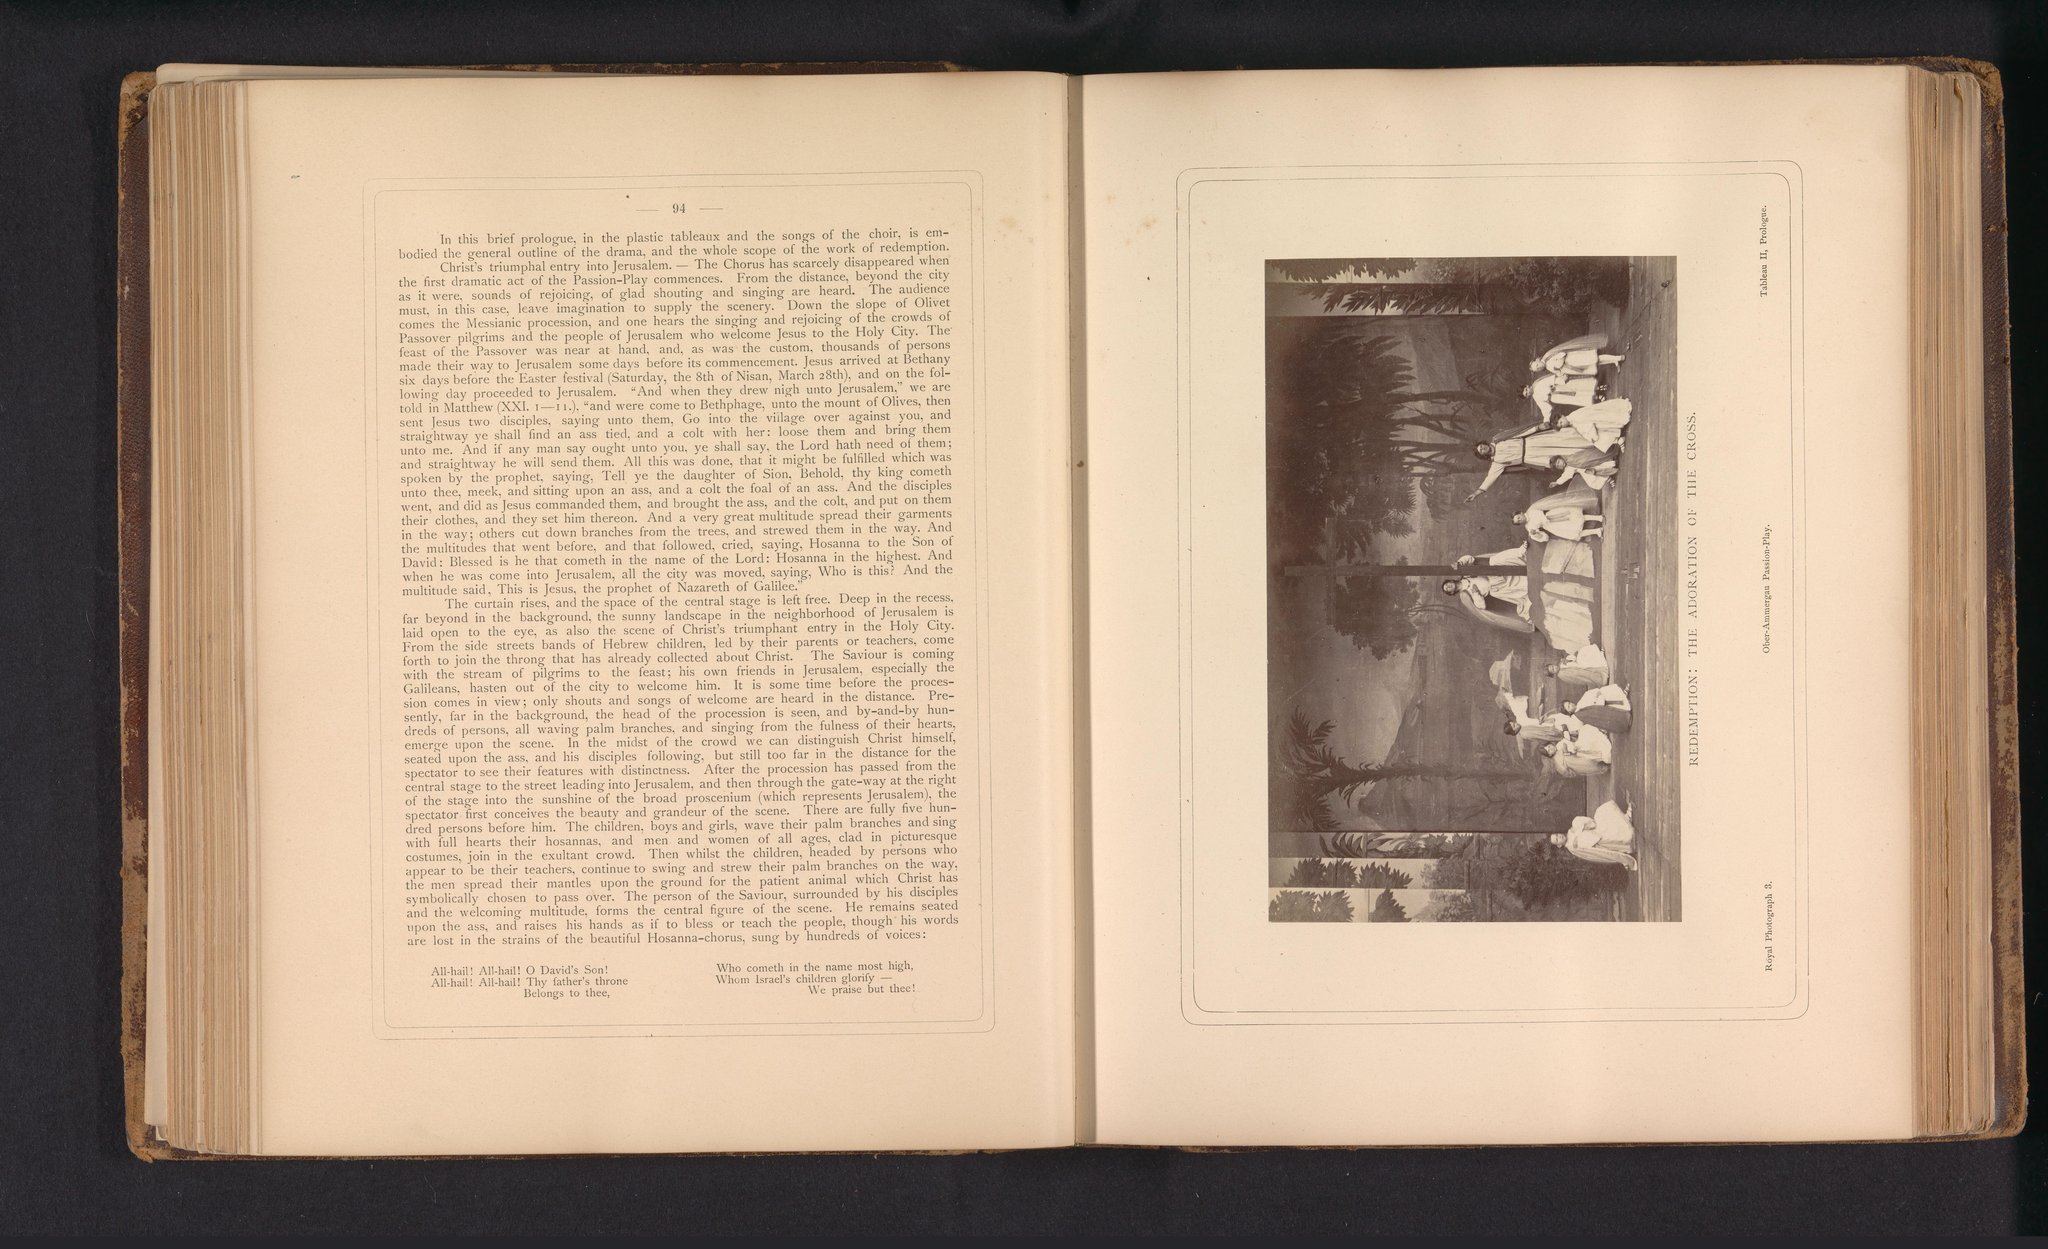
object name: page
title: Redemption: the adoration of the cross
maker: joseph albert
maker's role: printer, publisher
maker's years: 1825-1886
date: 1868-1873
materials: photographic support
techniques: albumen print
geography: oberammergau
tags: venerating the cross, group of actors, troupe; actors on the stage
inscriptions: number: ‘Royal Photograph 3.’